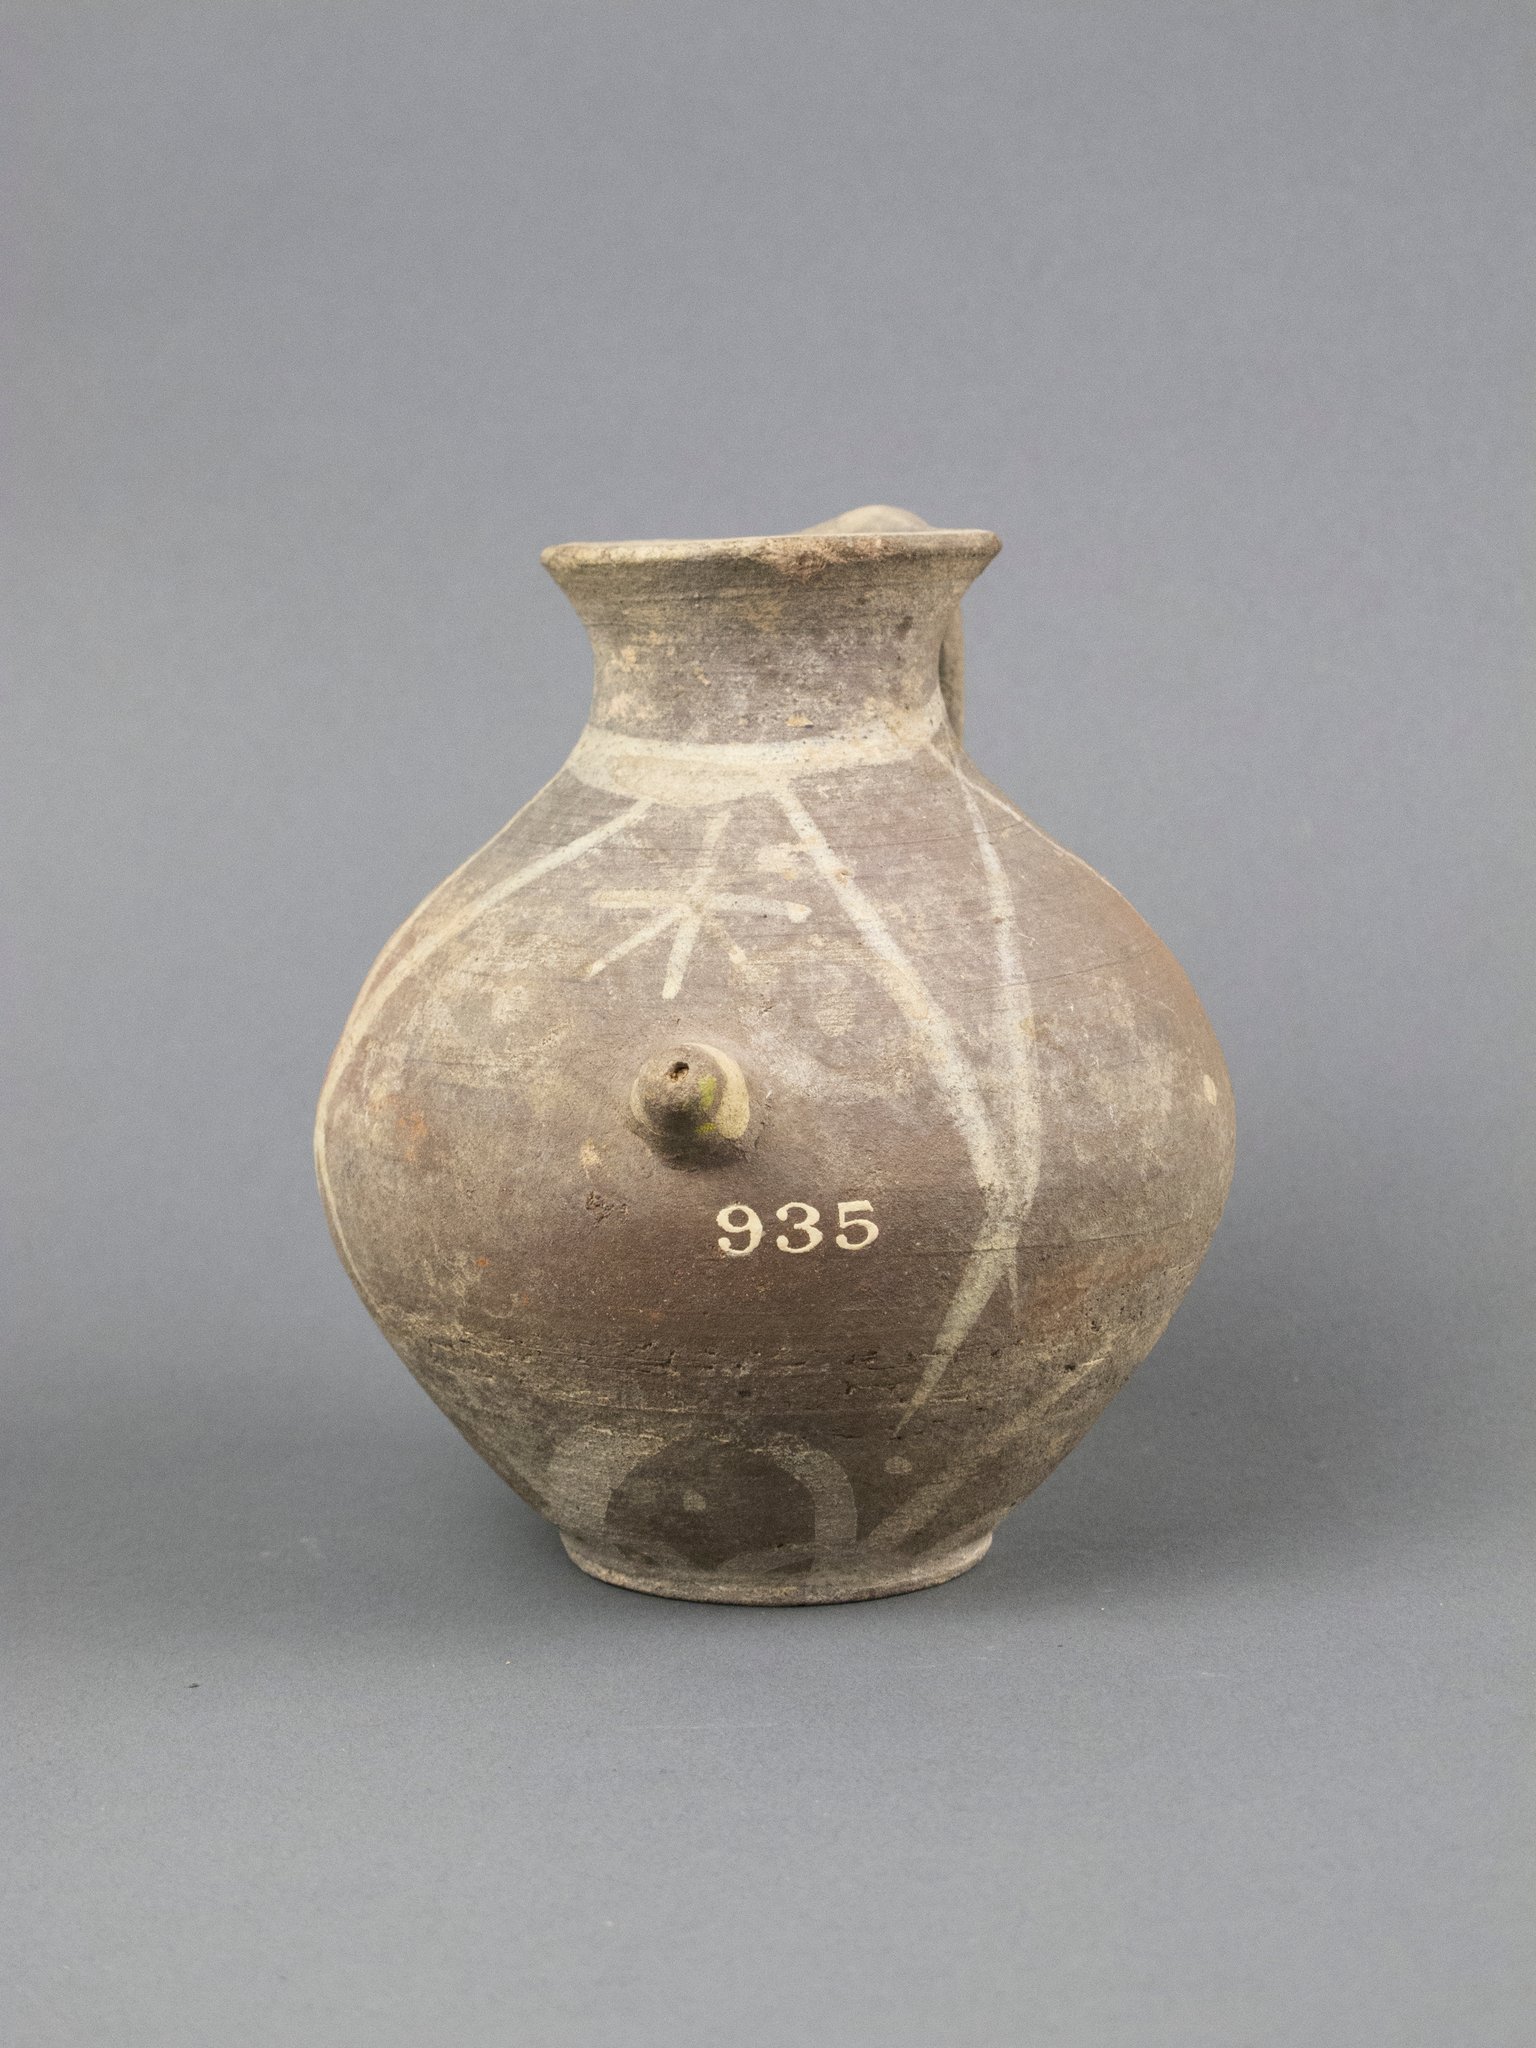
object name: jug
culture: cypriot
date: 507-323 BCE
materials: terracotta